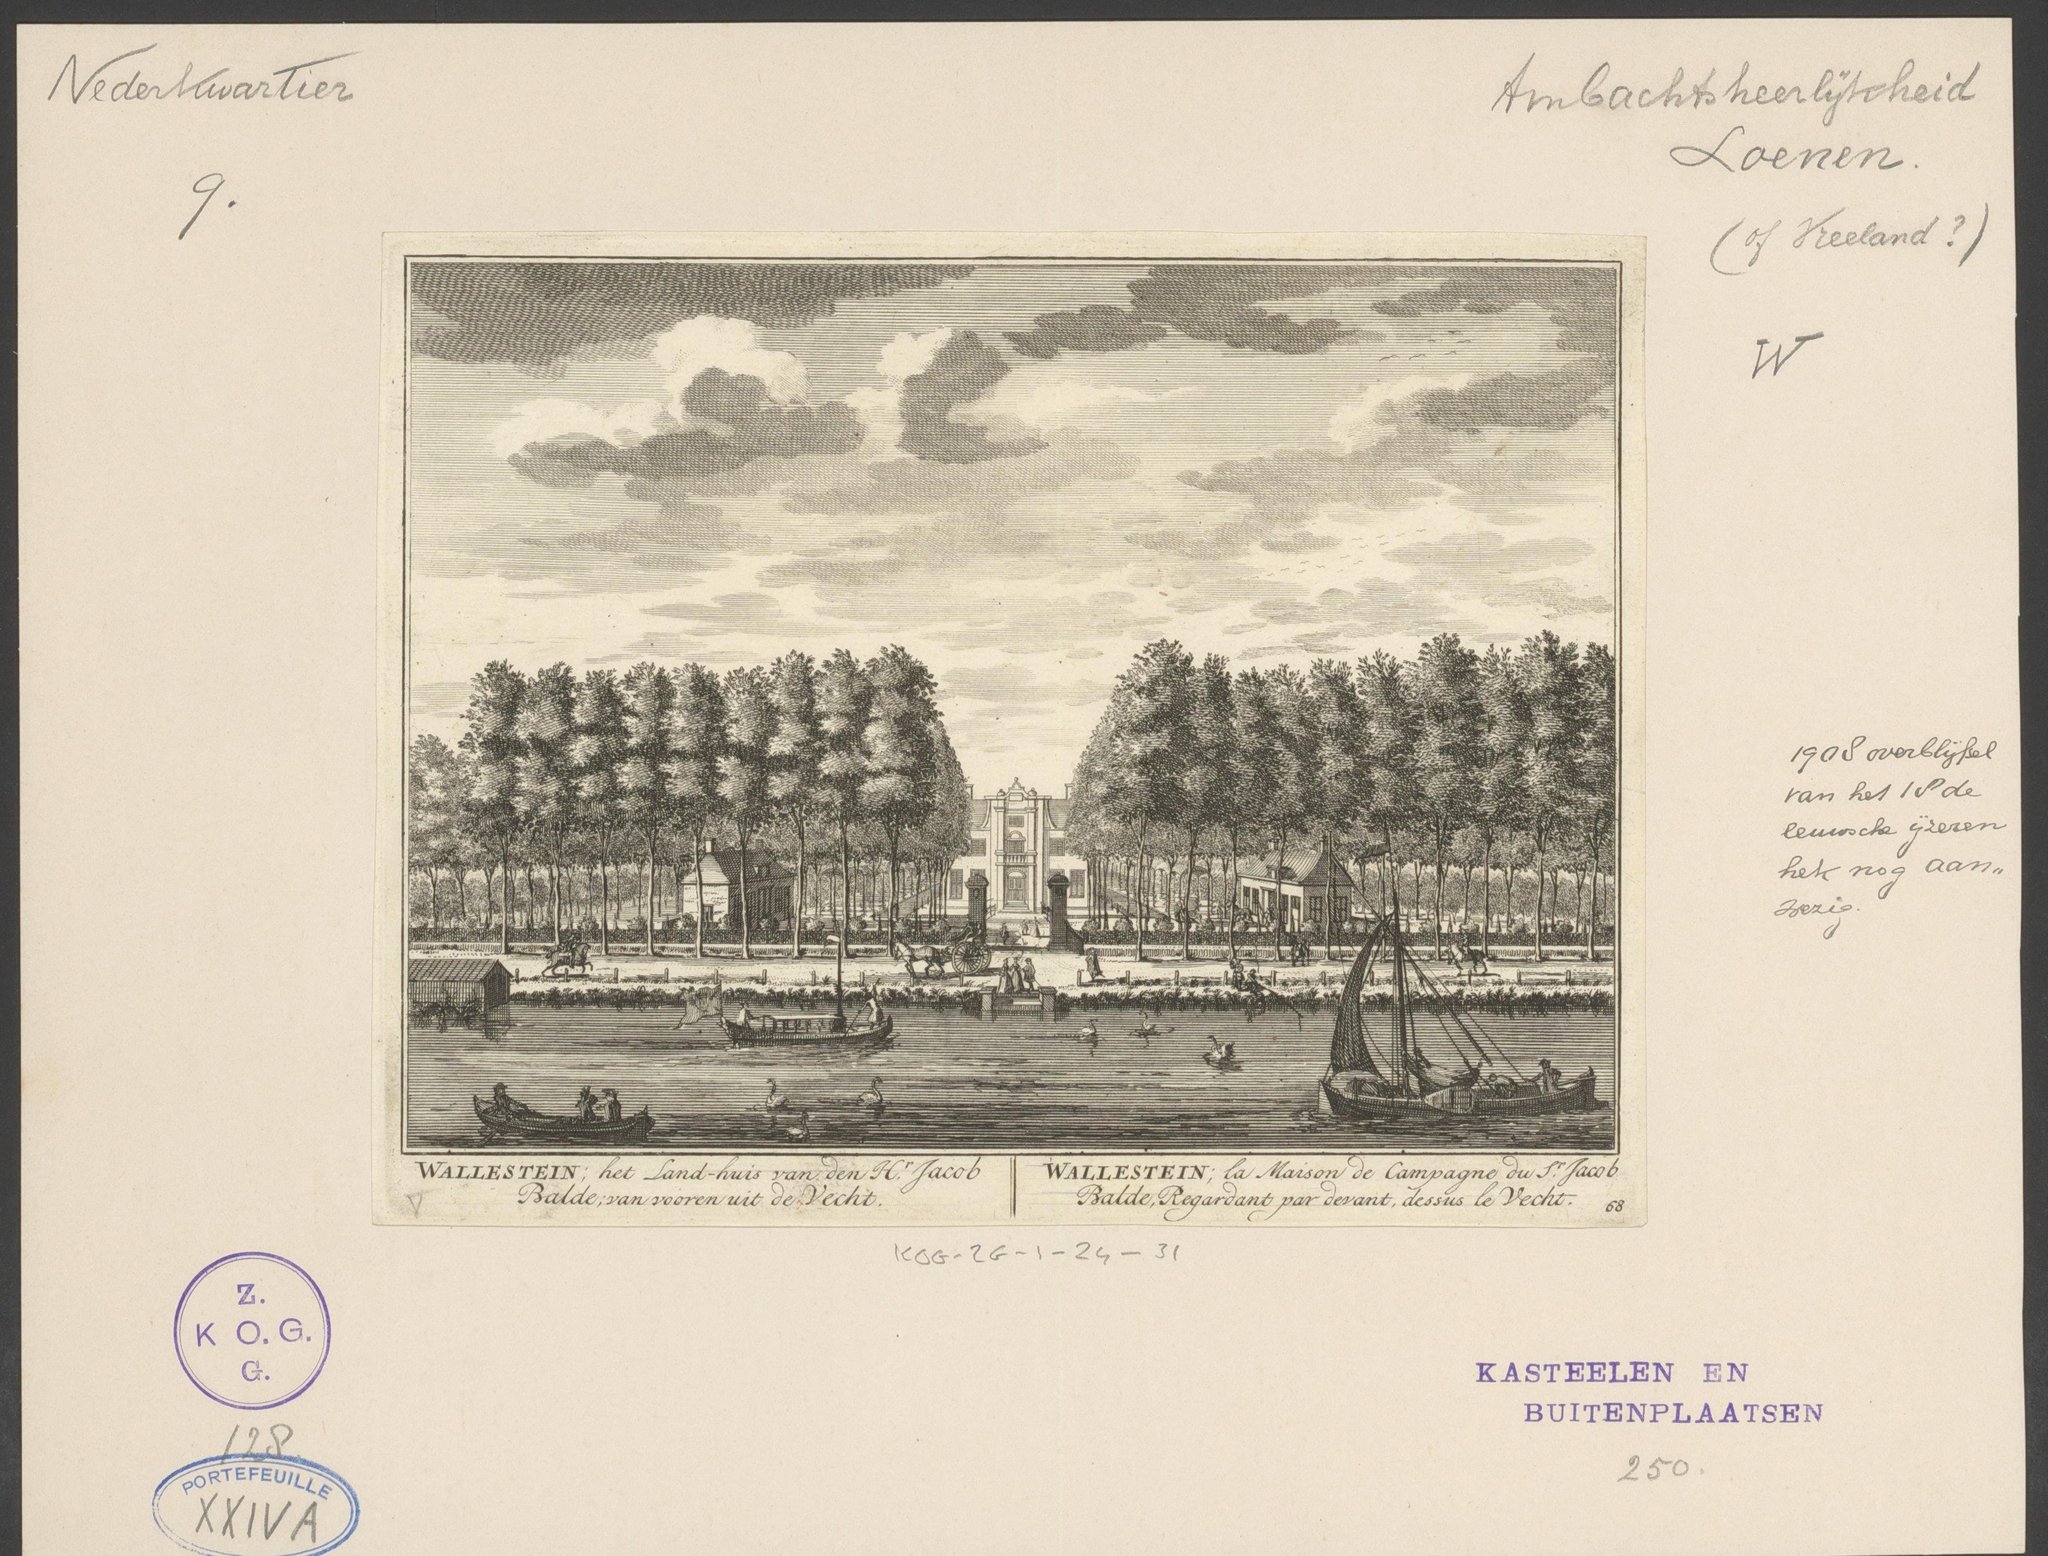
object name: book illustration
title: Wallestein; het Land-huis van den H. Jacob Balde; van vooren uit de Vecht / Wallestein; la Maison de Campagne du S. Jacob Balde, Regardant par devant devant, dessus le Vecht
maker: daniël stopendaal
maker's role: print maker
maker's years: 1672-1726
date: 1719-1790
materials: paper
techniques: engraving, etching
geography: amsterdam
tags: river (+ landscape with figures, staffage), country-house, vecht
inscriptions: collector's mark: Lugt 1641, stamp, stamp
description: Prent gebruikt in: Leth, Andries de. De zegepraalende Vecht, vertoonende verscheidene gesichten van lustplaatsen, heeren huysen en dorpen, beginnende van Uitrecht en met Muyden besluytende (...). Amsterdam: Weduwe Nicolaus Visscher, 1719. Prent ook gebruikt in: Brouërius van Nidek, Matthaeus. De Vechtstroom, van Utrecht tot Muiden (...). Amsterdam: H. Gartman, W. Vermandel en J.W. Smit, 1790.